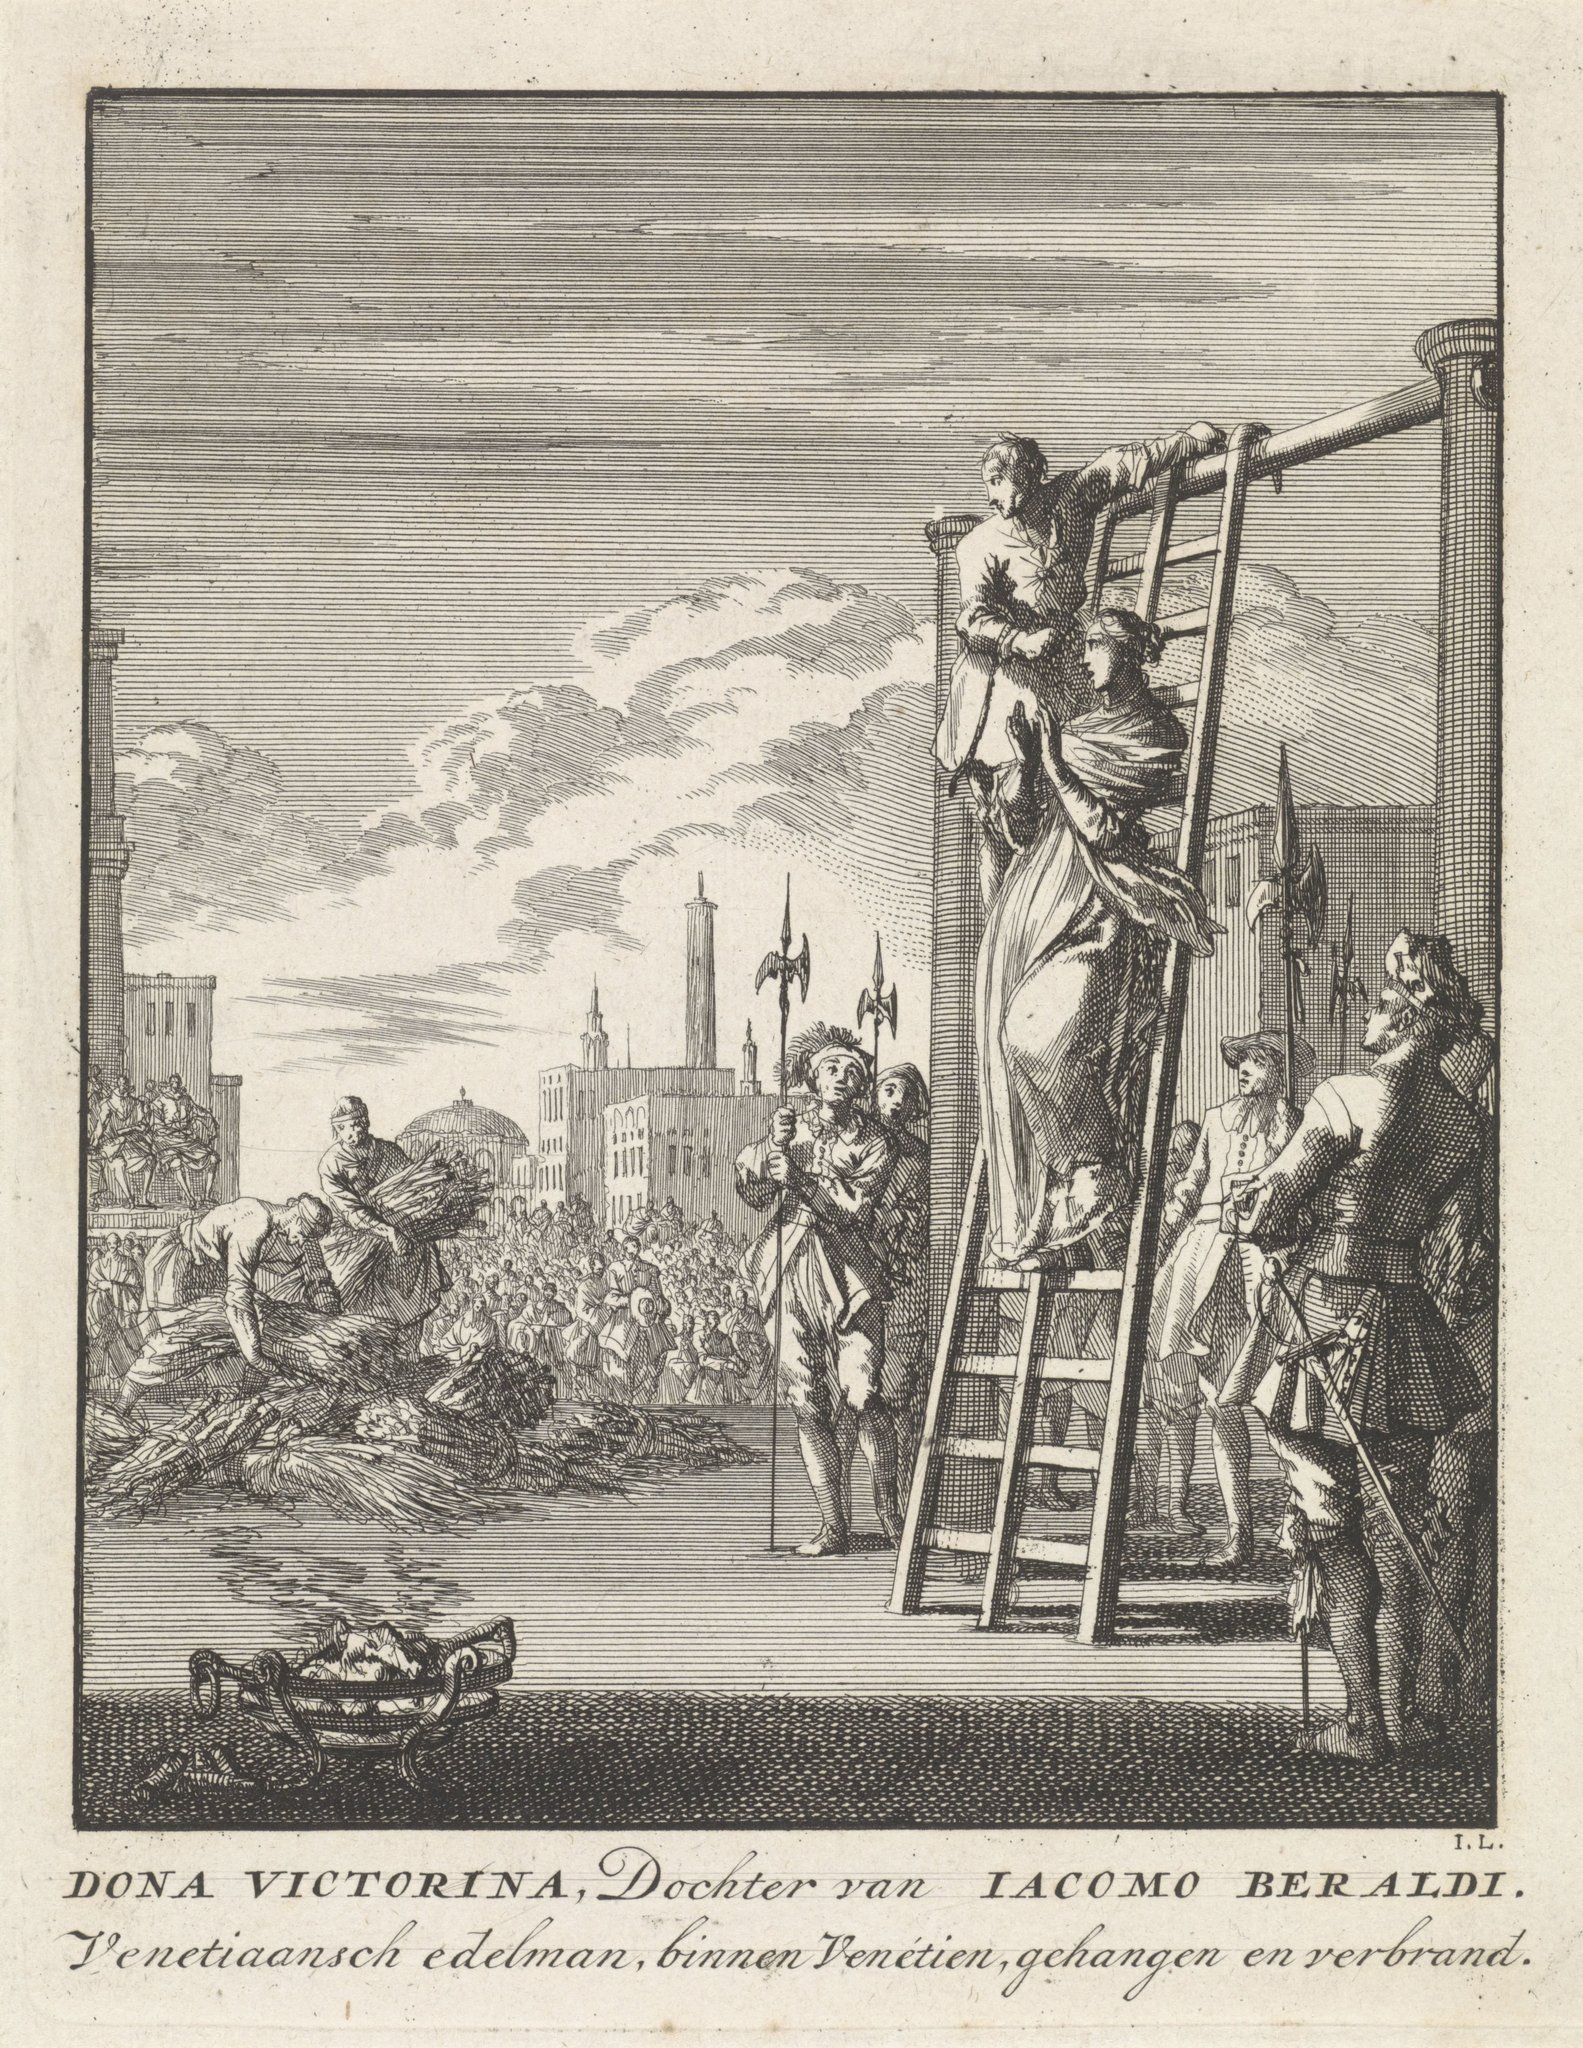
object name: history print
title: Dona Victorina, Dochter van Jacomo Beraldi, Venetiaansch edelman, binnen Venetien, gehangen en verbrand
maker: jan luyken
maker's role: draughtsman, print maker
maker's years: 1649-1712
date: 1699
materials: paper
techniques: etching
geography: amsterdam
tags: violent death by burning at the stake; pyre, on the scaffold or place of execution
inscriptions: collector's mark: Lugt 2228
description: Victorina, de dochter van de edelman Iacomo Beraldi, wordt aan een ladder gebonden om verbrand te worden. Ze wordt terechtgesteld vanwege de moord op haar man, Ludovico Fassino. Op de achtergrond verzamelen de beulen stro en hout voor de brandstapel. Op de achtergrond het dogepaleis van Venetië.